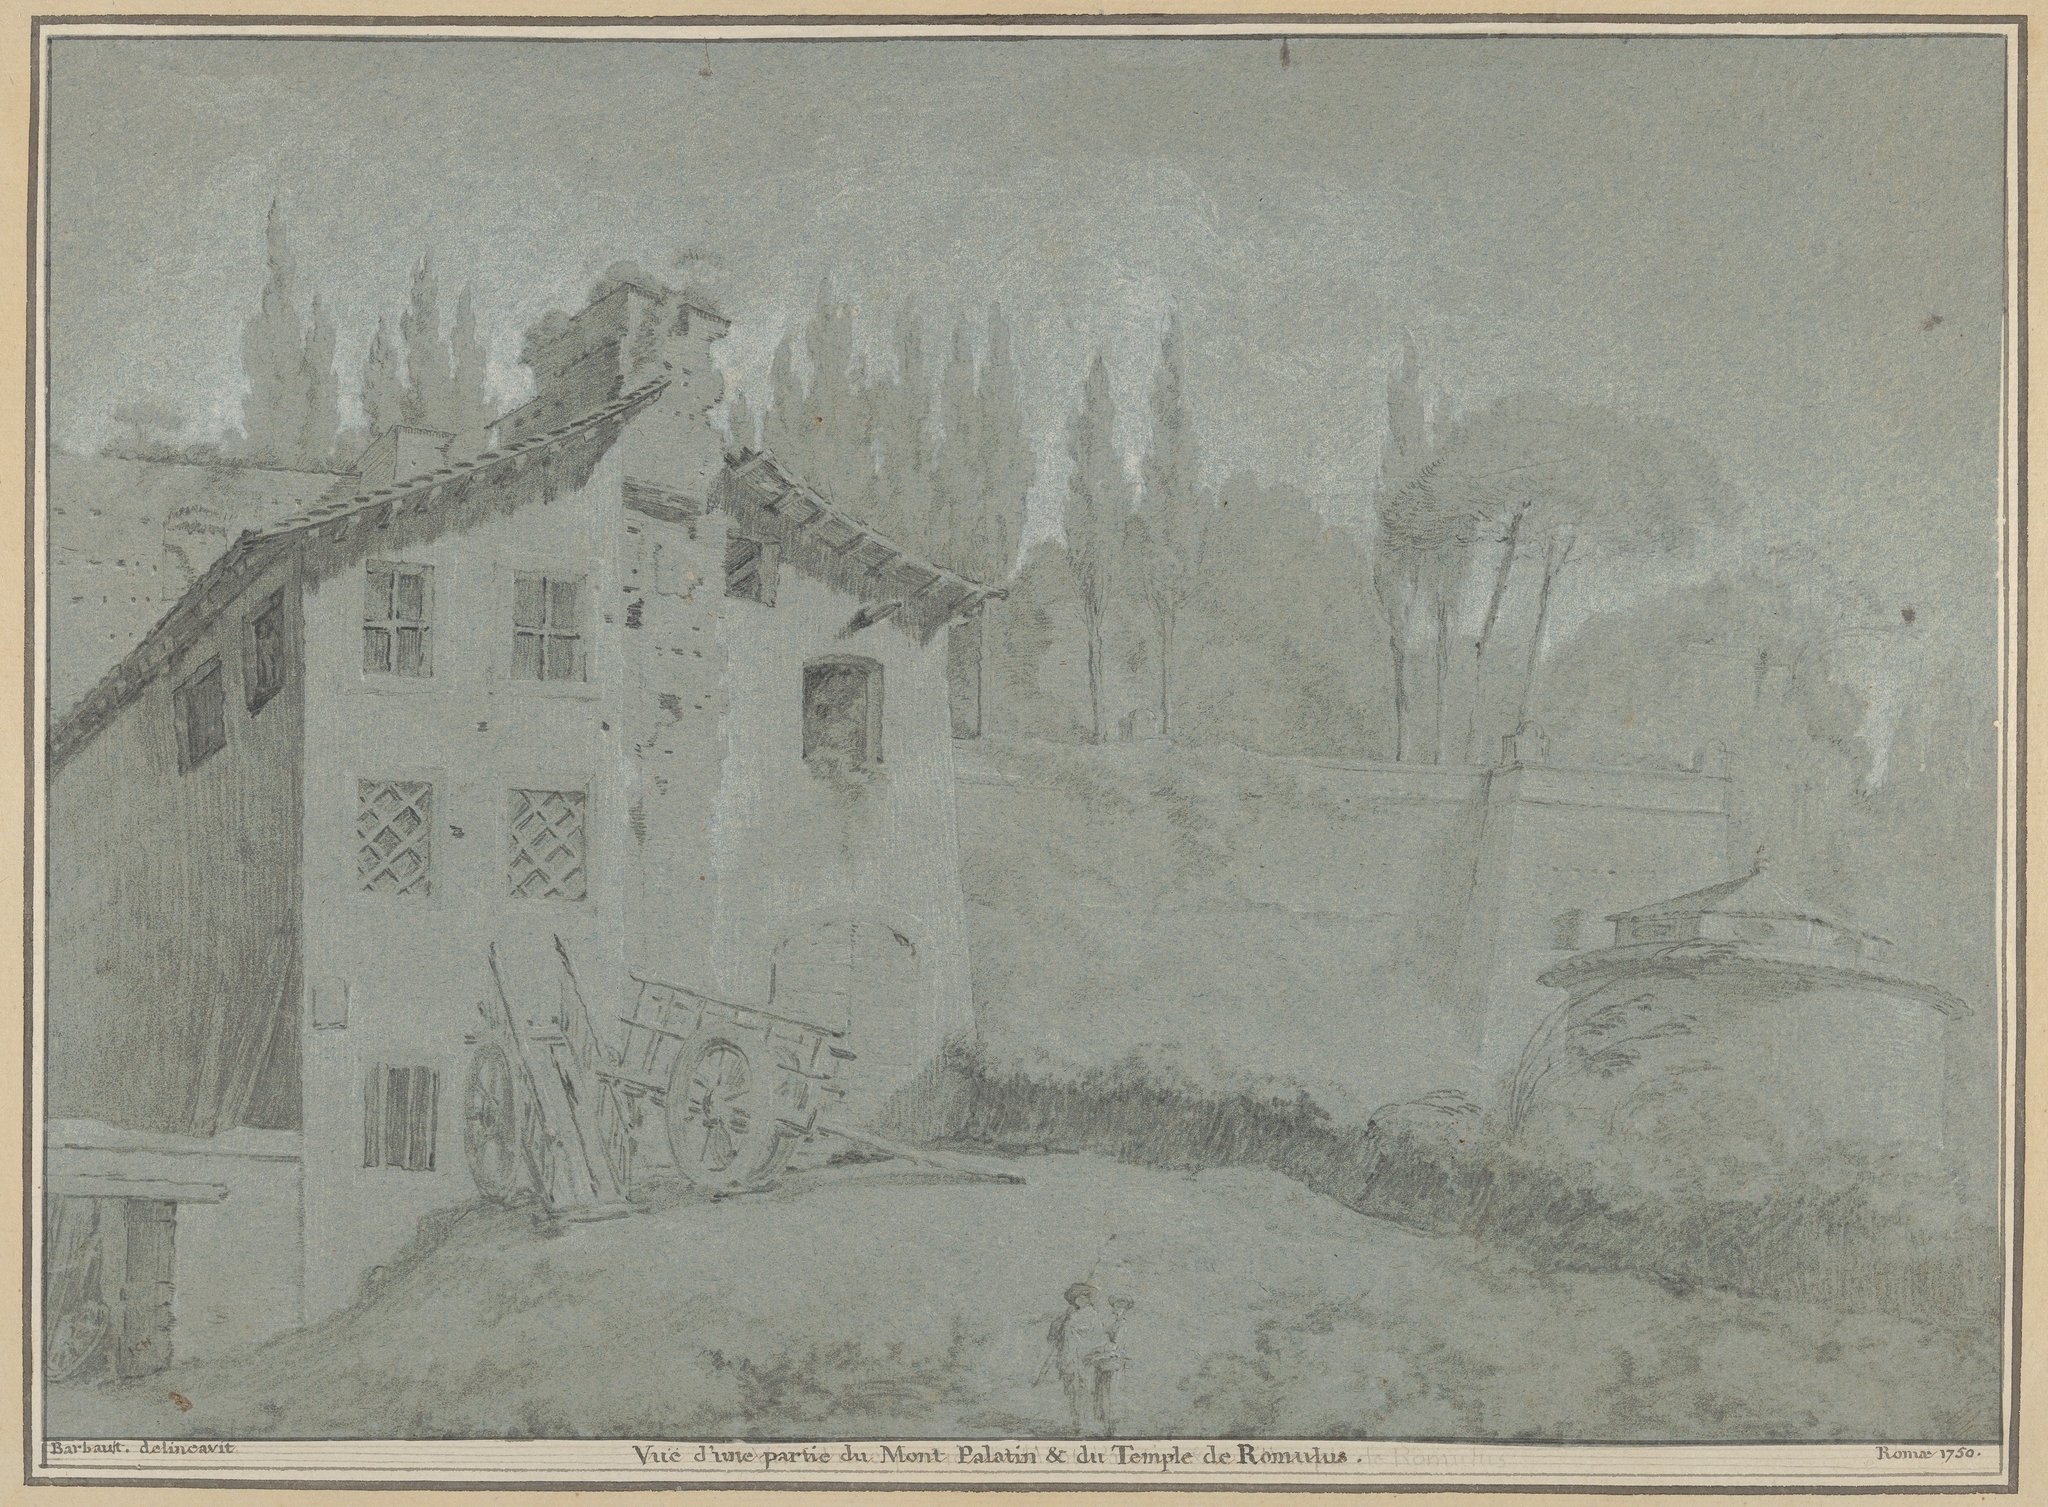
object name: drawing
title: View of the Palatine Hill and the Temple of Romulus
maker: jean barbault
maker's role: artist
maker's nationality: french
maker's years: 1718-1762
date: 1750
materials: chalk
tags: temples